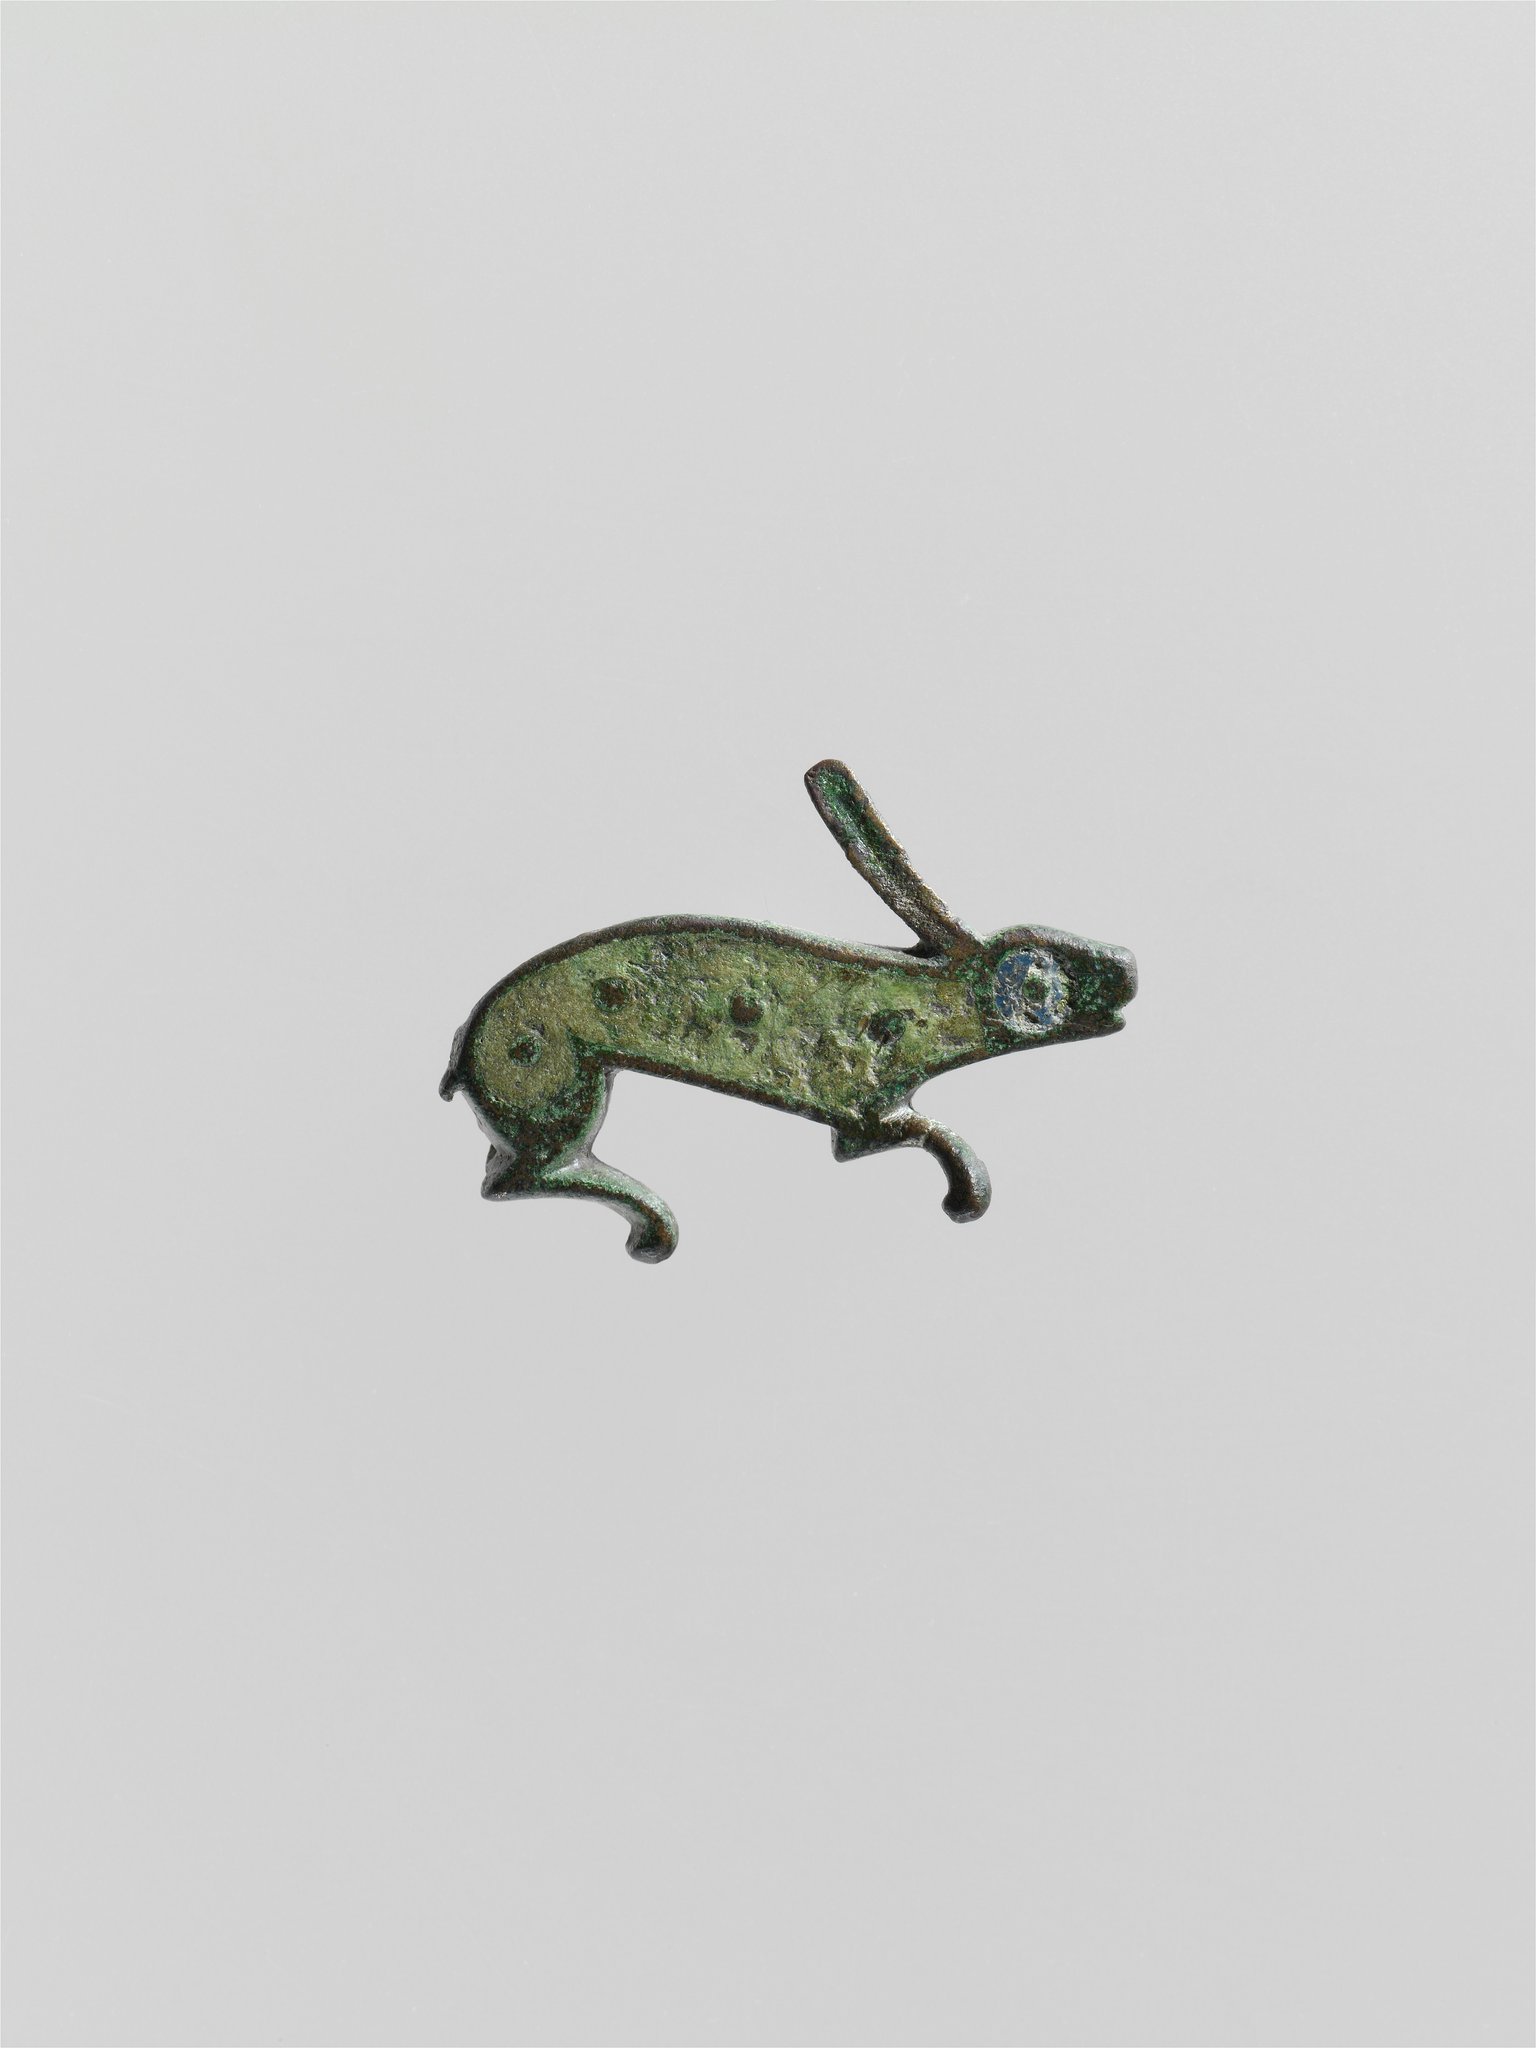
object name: brooch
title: Brooch in the Form of a Rabbit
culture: roman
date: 100-300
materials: copper alloy, enamel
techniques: enamel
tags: rabbits